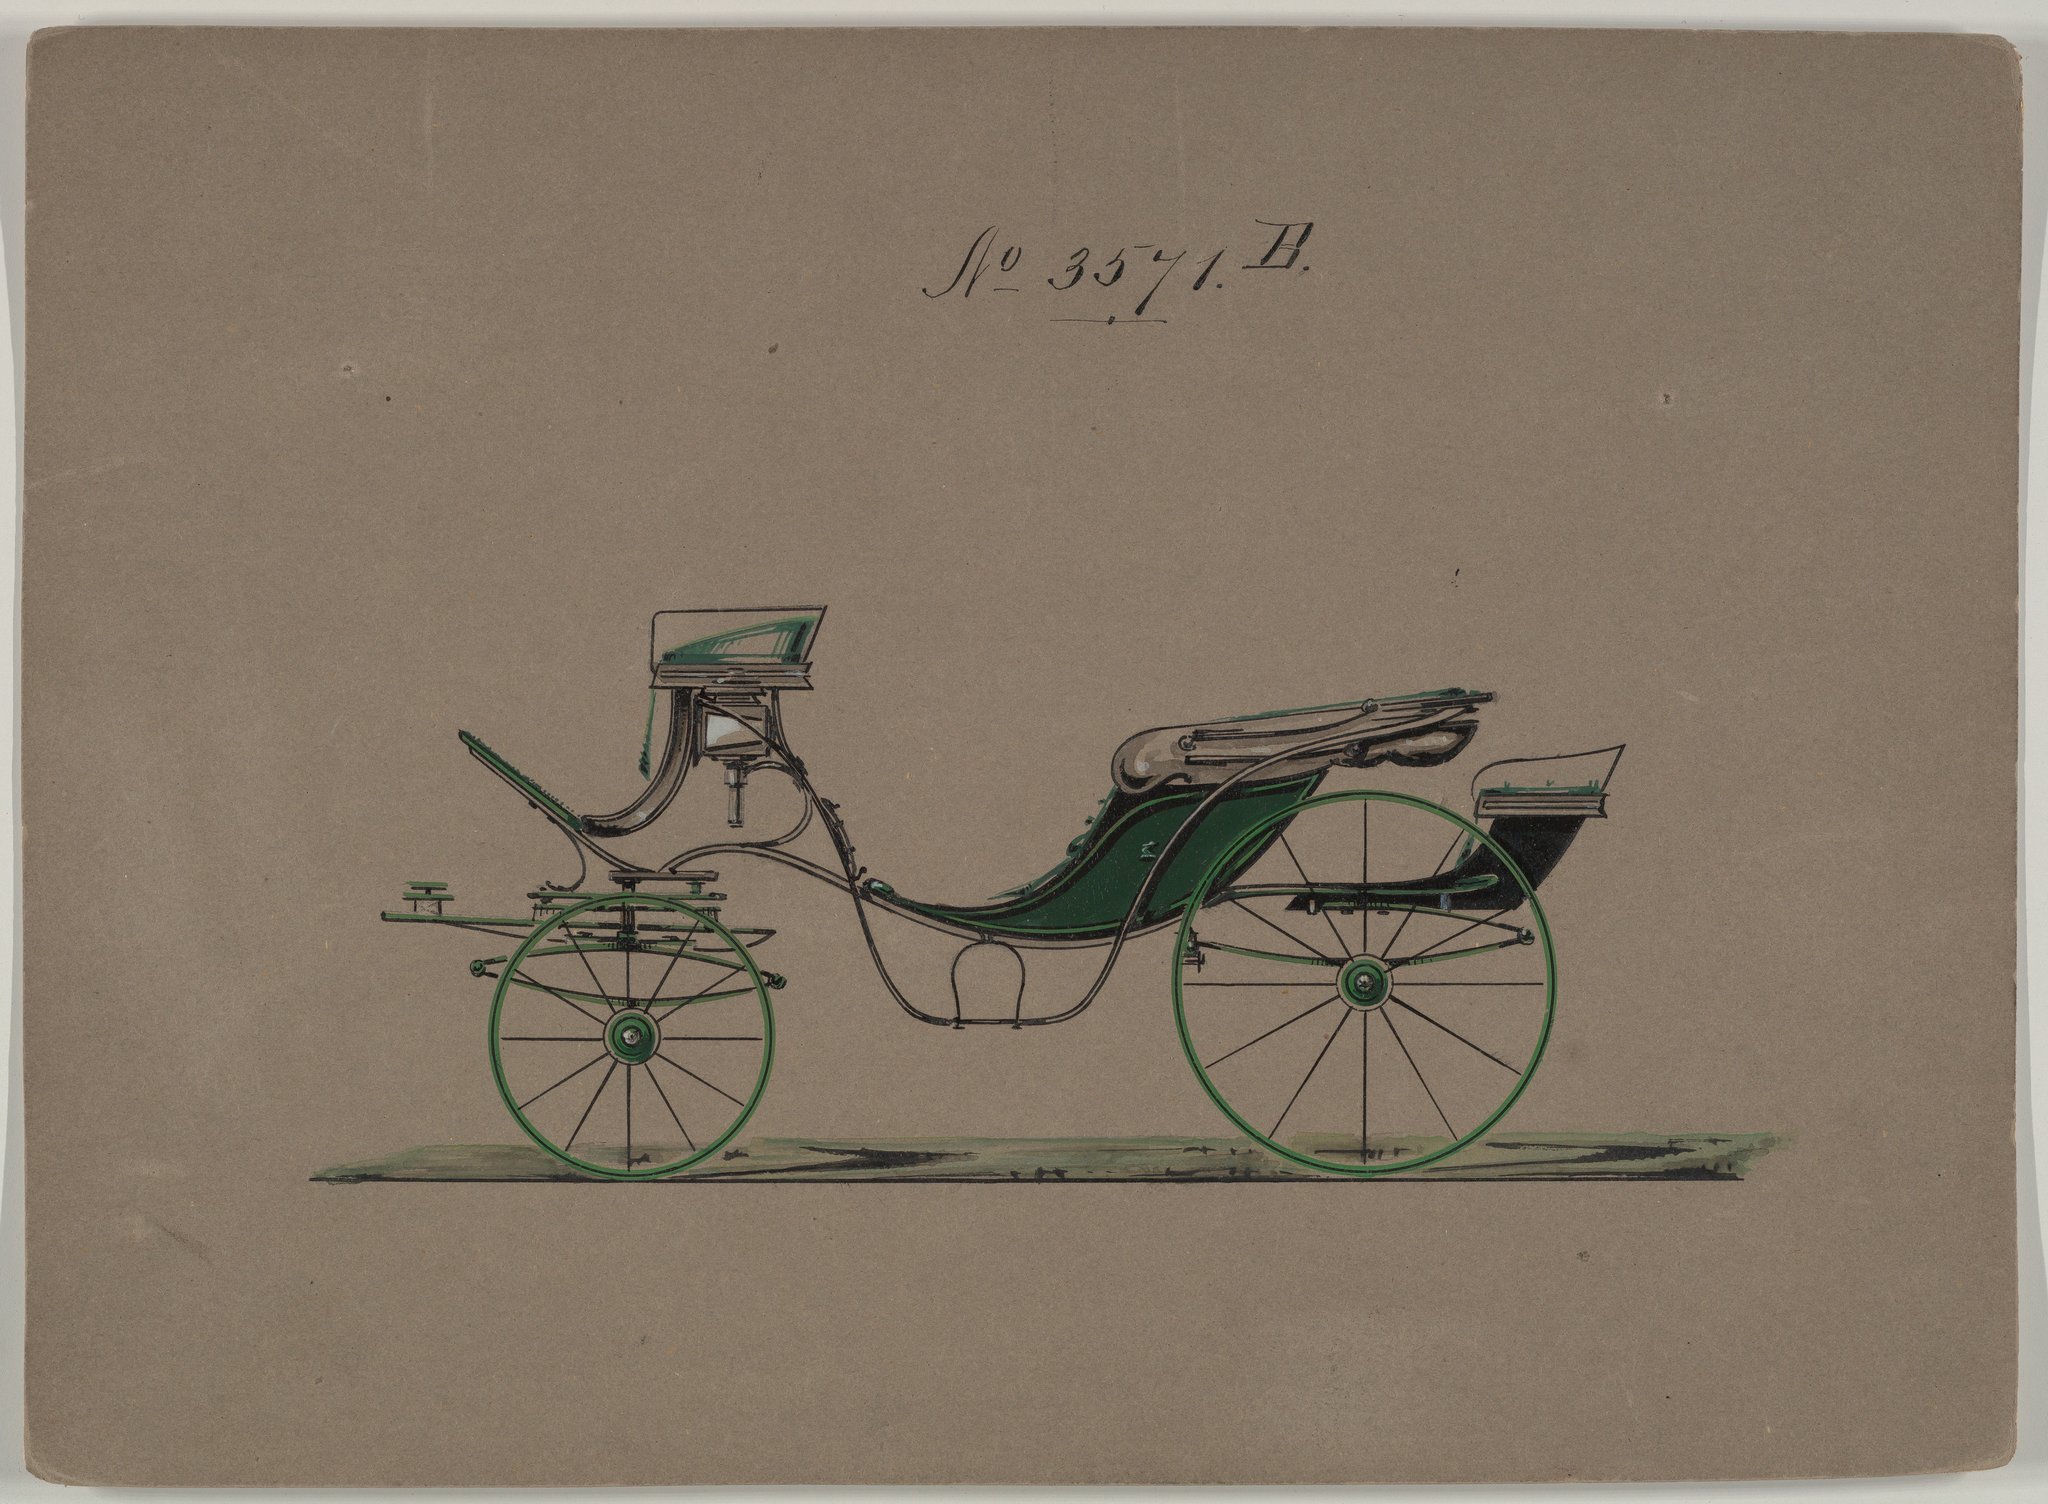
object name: drawing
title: Design for Cabriolet or Victoria, no. 3571b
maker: brewster & co.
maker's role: manufacturer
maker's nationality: american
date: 1880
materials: gouache, gum arabic, ink, watercolor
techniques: pen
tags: carriages